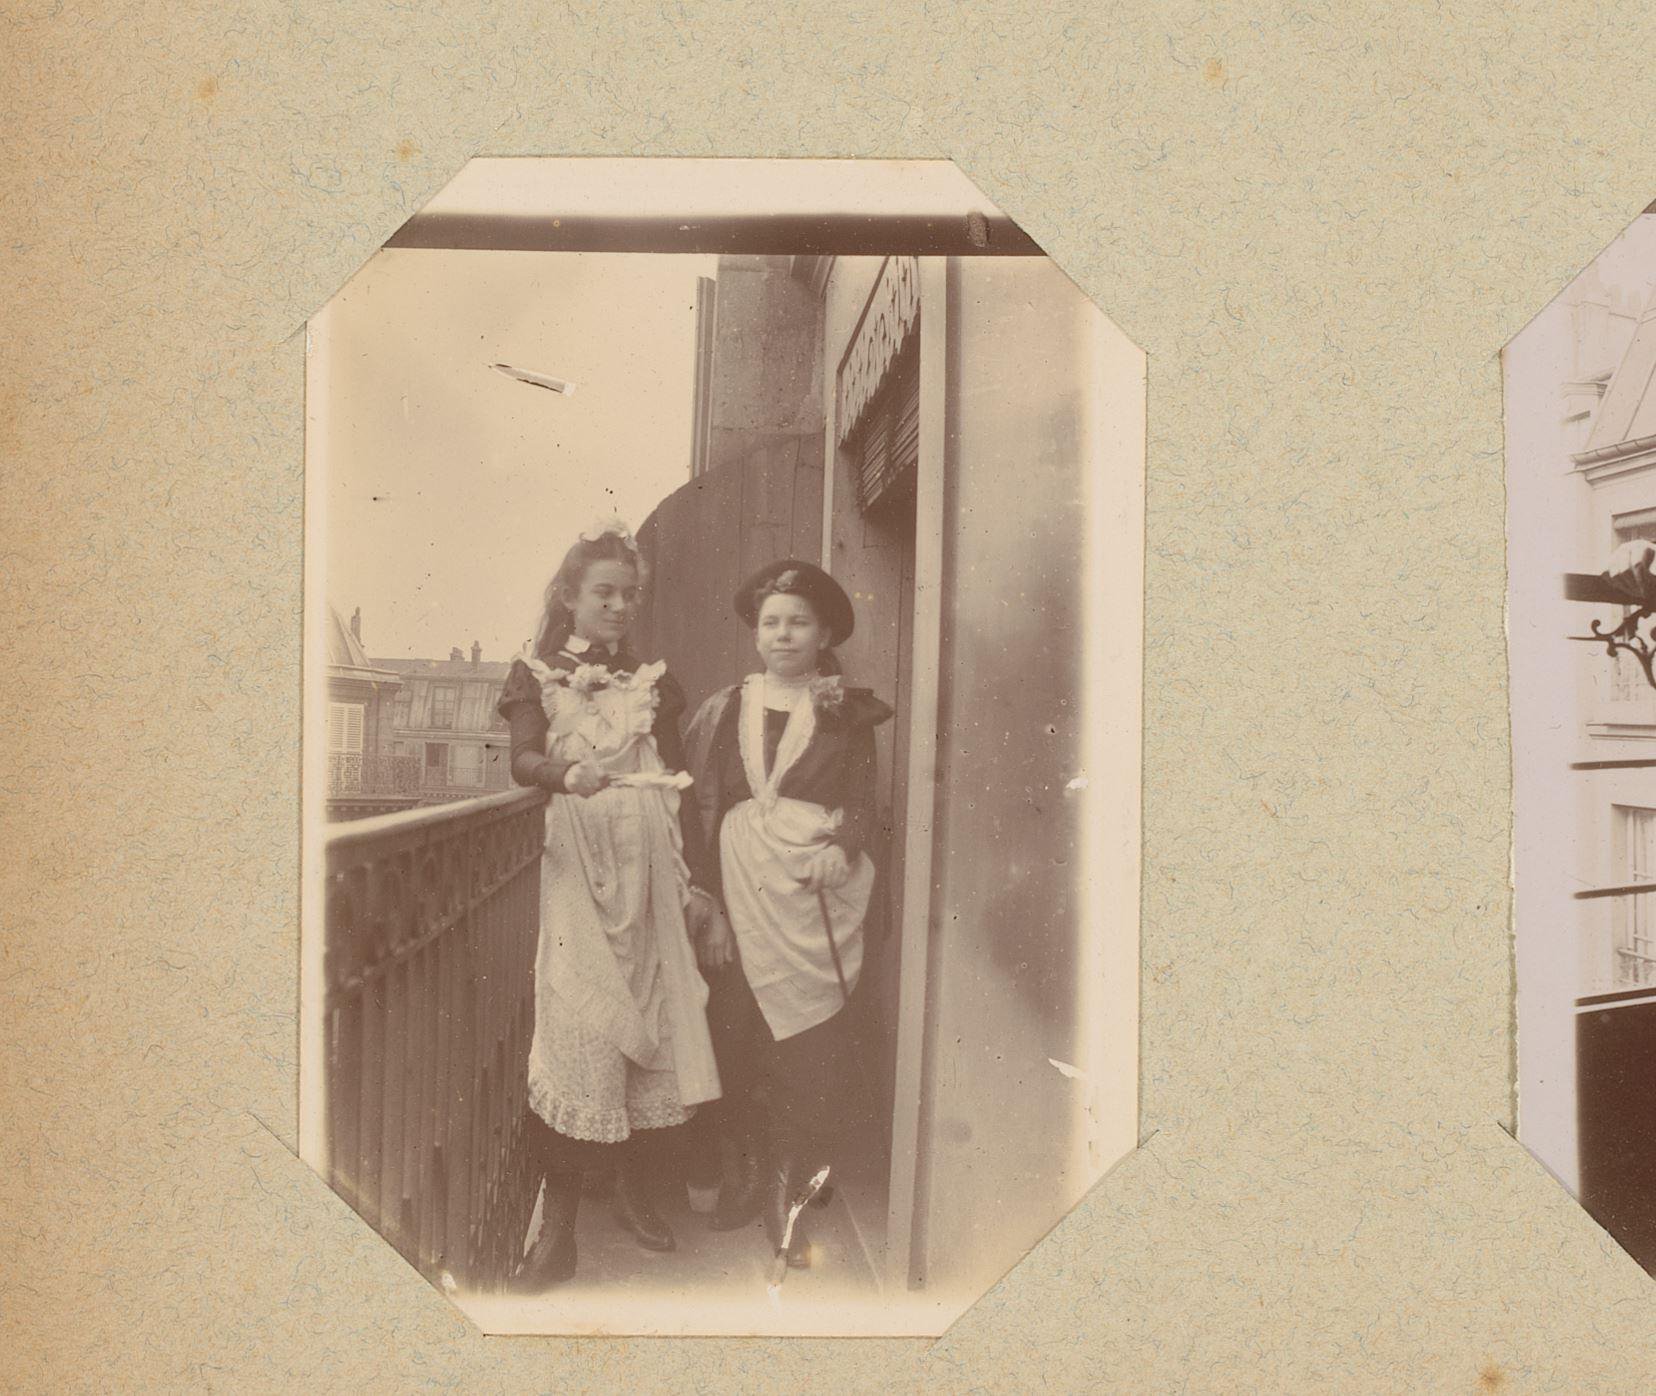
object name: album leaf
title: Twee meisjes met schorten, waarschijnlijk dienstmeisjes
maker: Anonymous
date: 1897-1900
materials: paper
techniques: gelatin silver print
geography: france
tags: maid ~ house personnel, france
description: Over de foto is een ander negatief afgedrukt van een voorstelling van bomen.